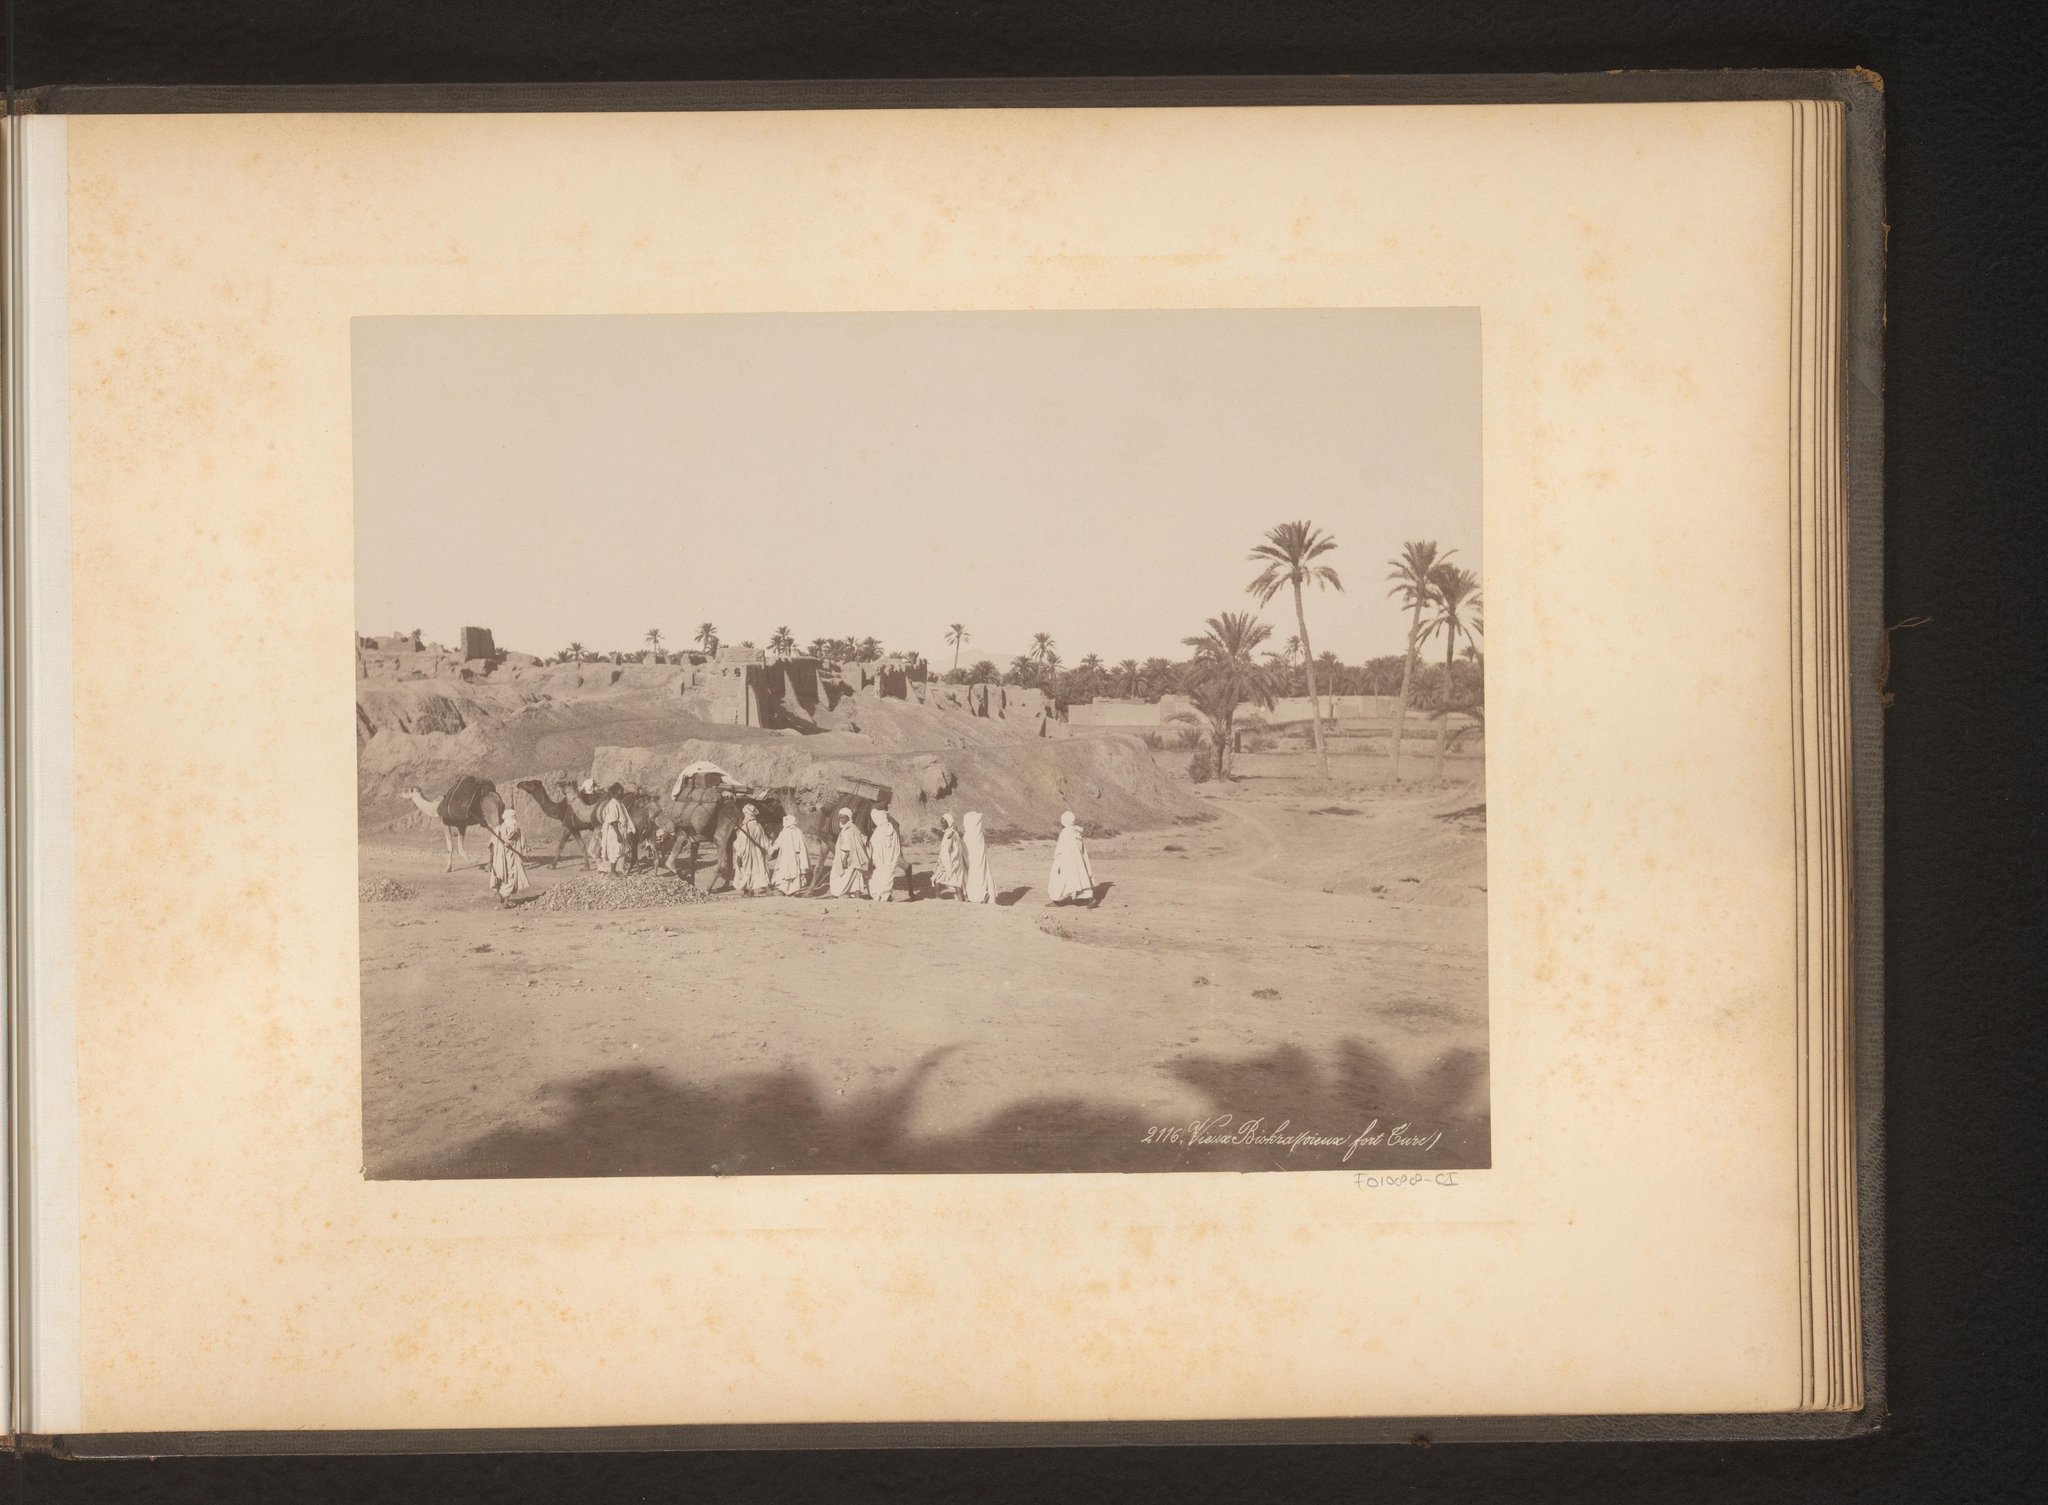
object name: photograph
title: Vieux Biskra (vieux fort Cure)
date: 1880-1900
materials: photographic support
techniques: albumen print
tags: ruin of a building ~ architecture, fortifications, military engineering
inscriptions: check stamp: ‘J. Kuhn Editeur/ 220 Rue de Rivoli Paris’, number: ‘2116’